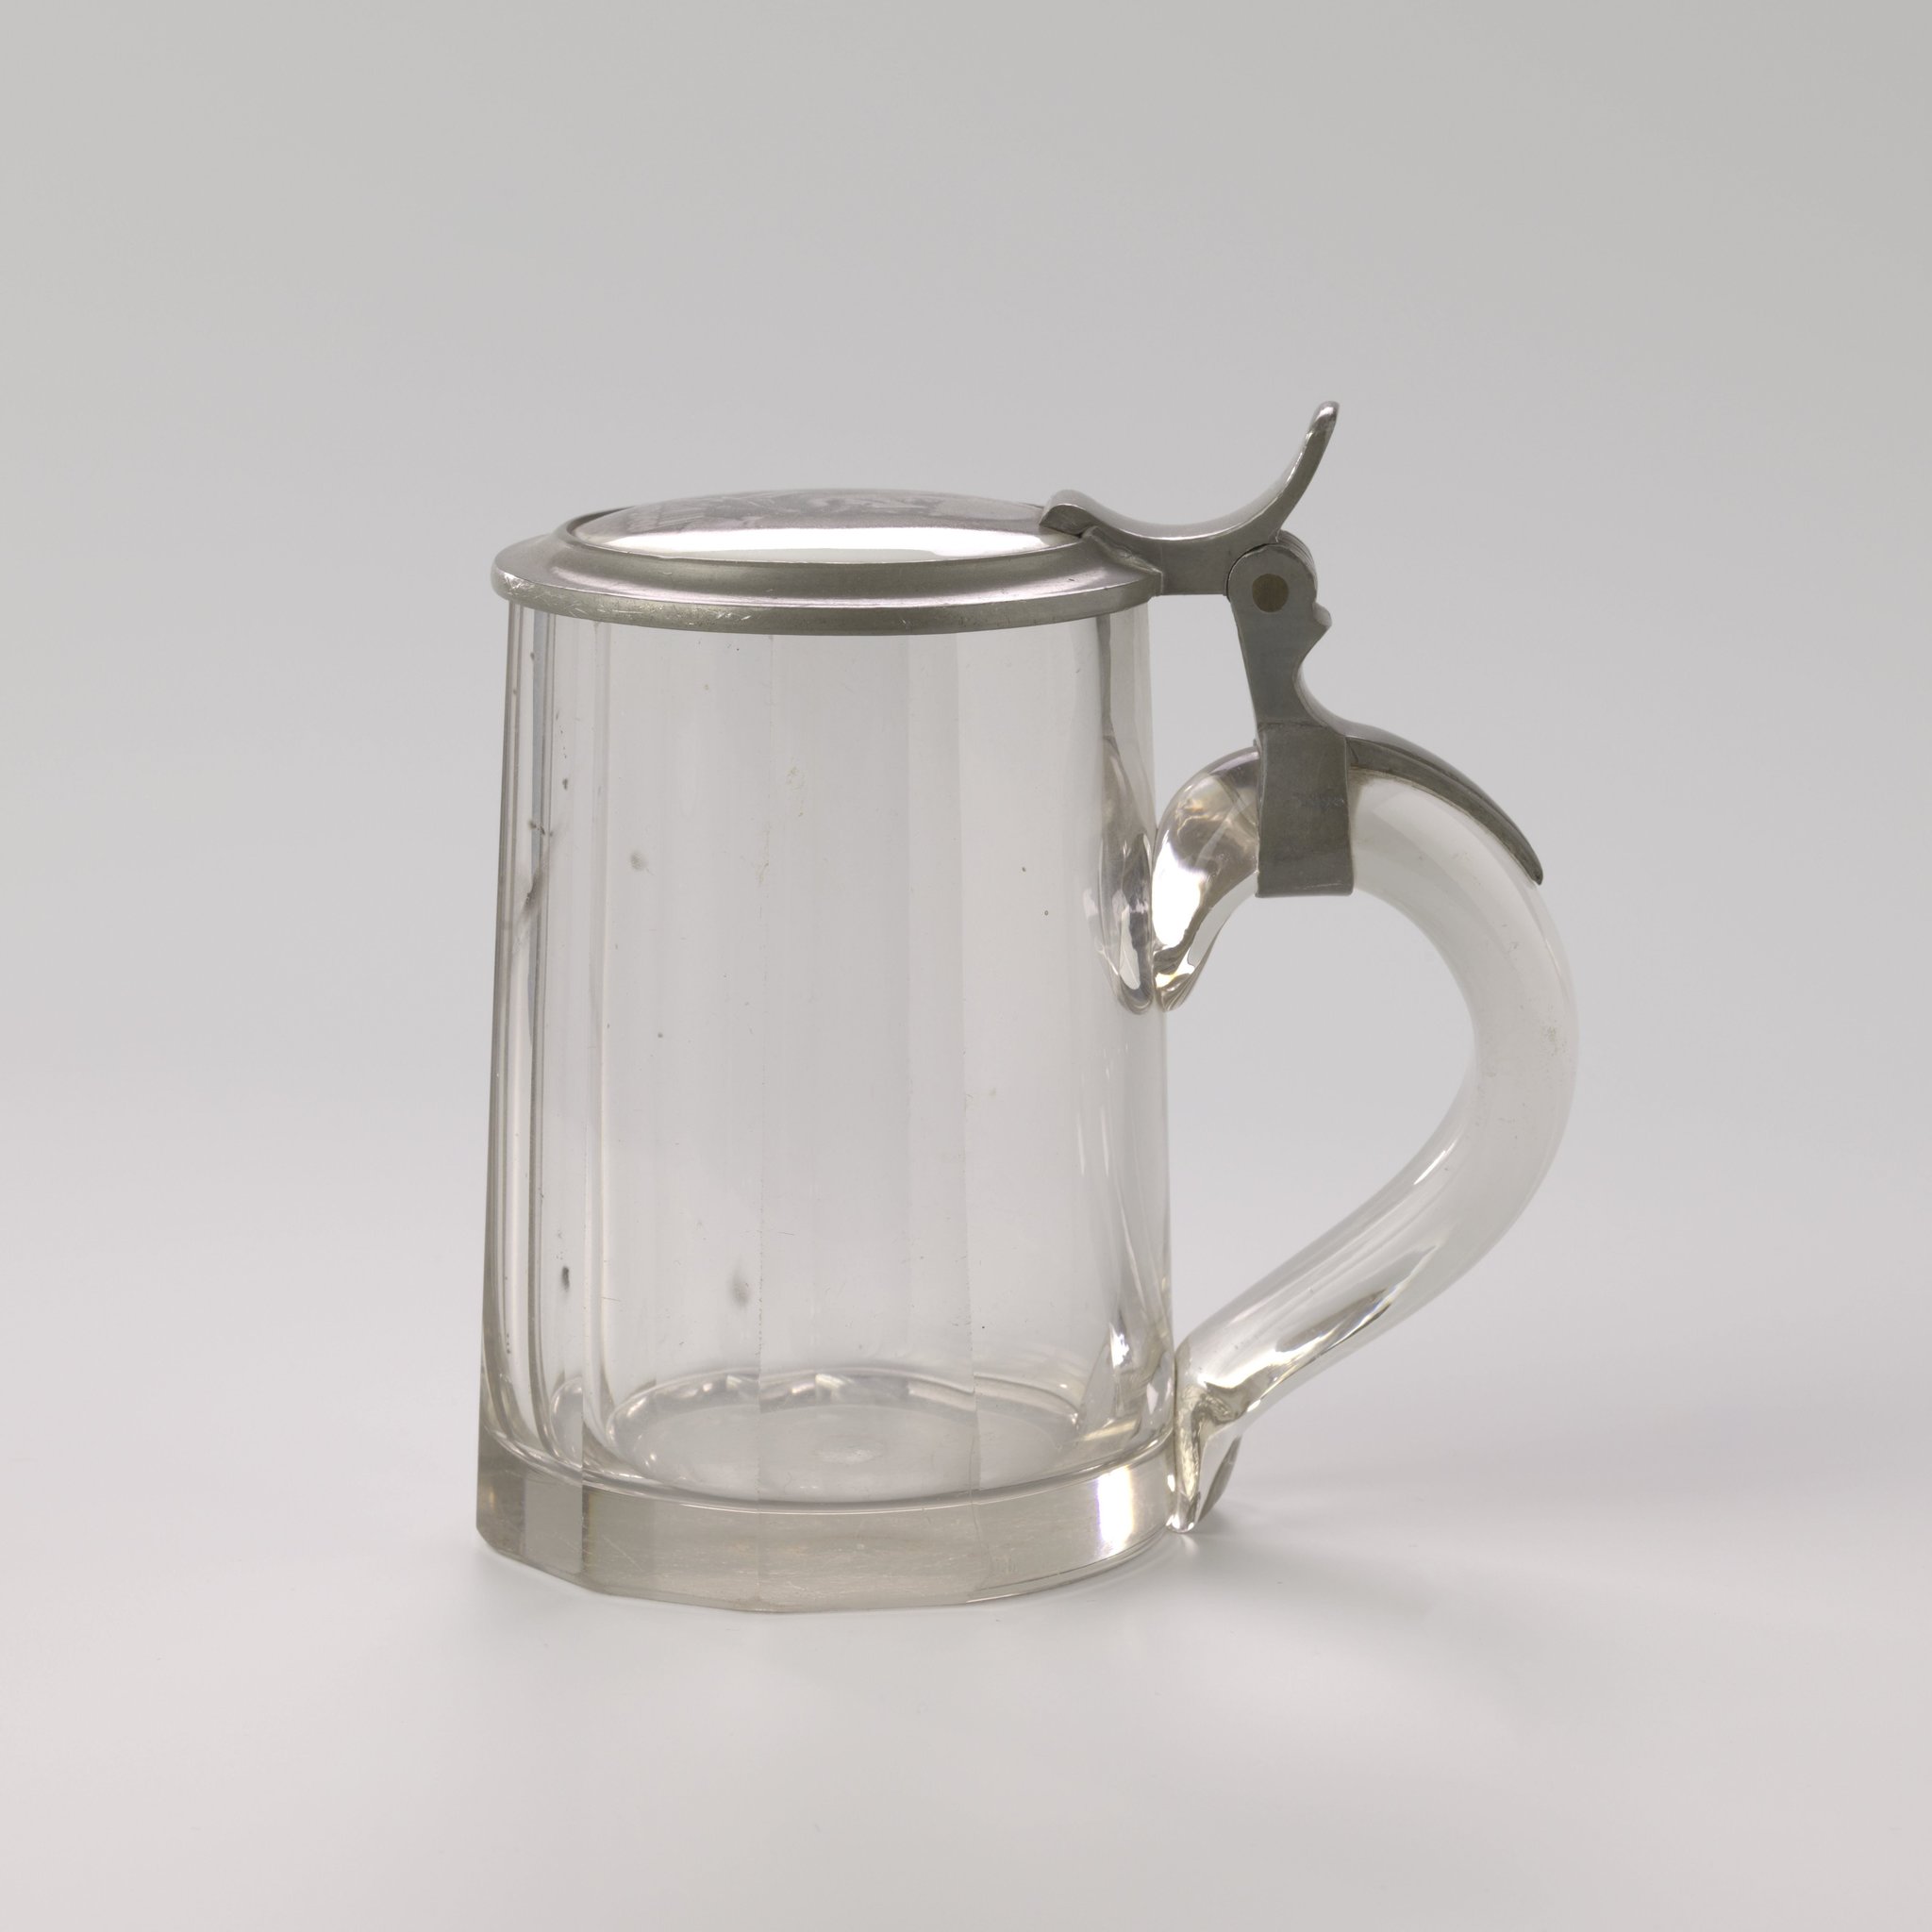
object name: stave tankard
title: Bierpul met portret keizer Wilhelm I, 'Geflügel Ausstellung 1872 / Preuss: Hof: Altenburg'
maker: Anonymous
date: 1872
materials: glass, tin